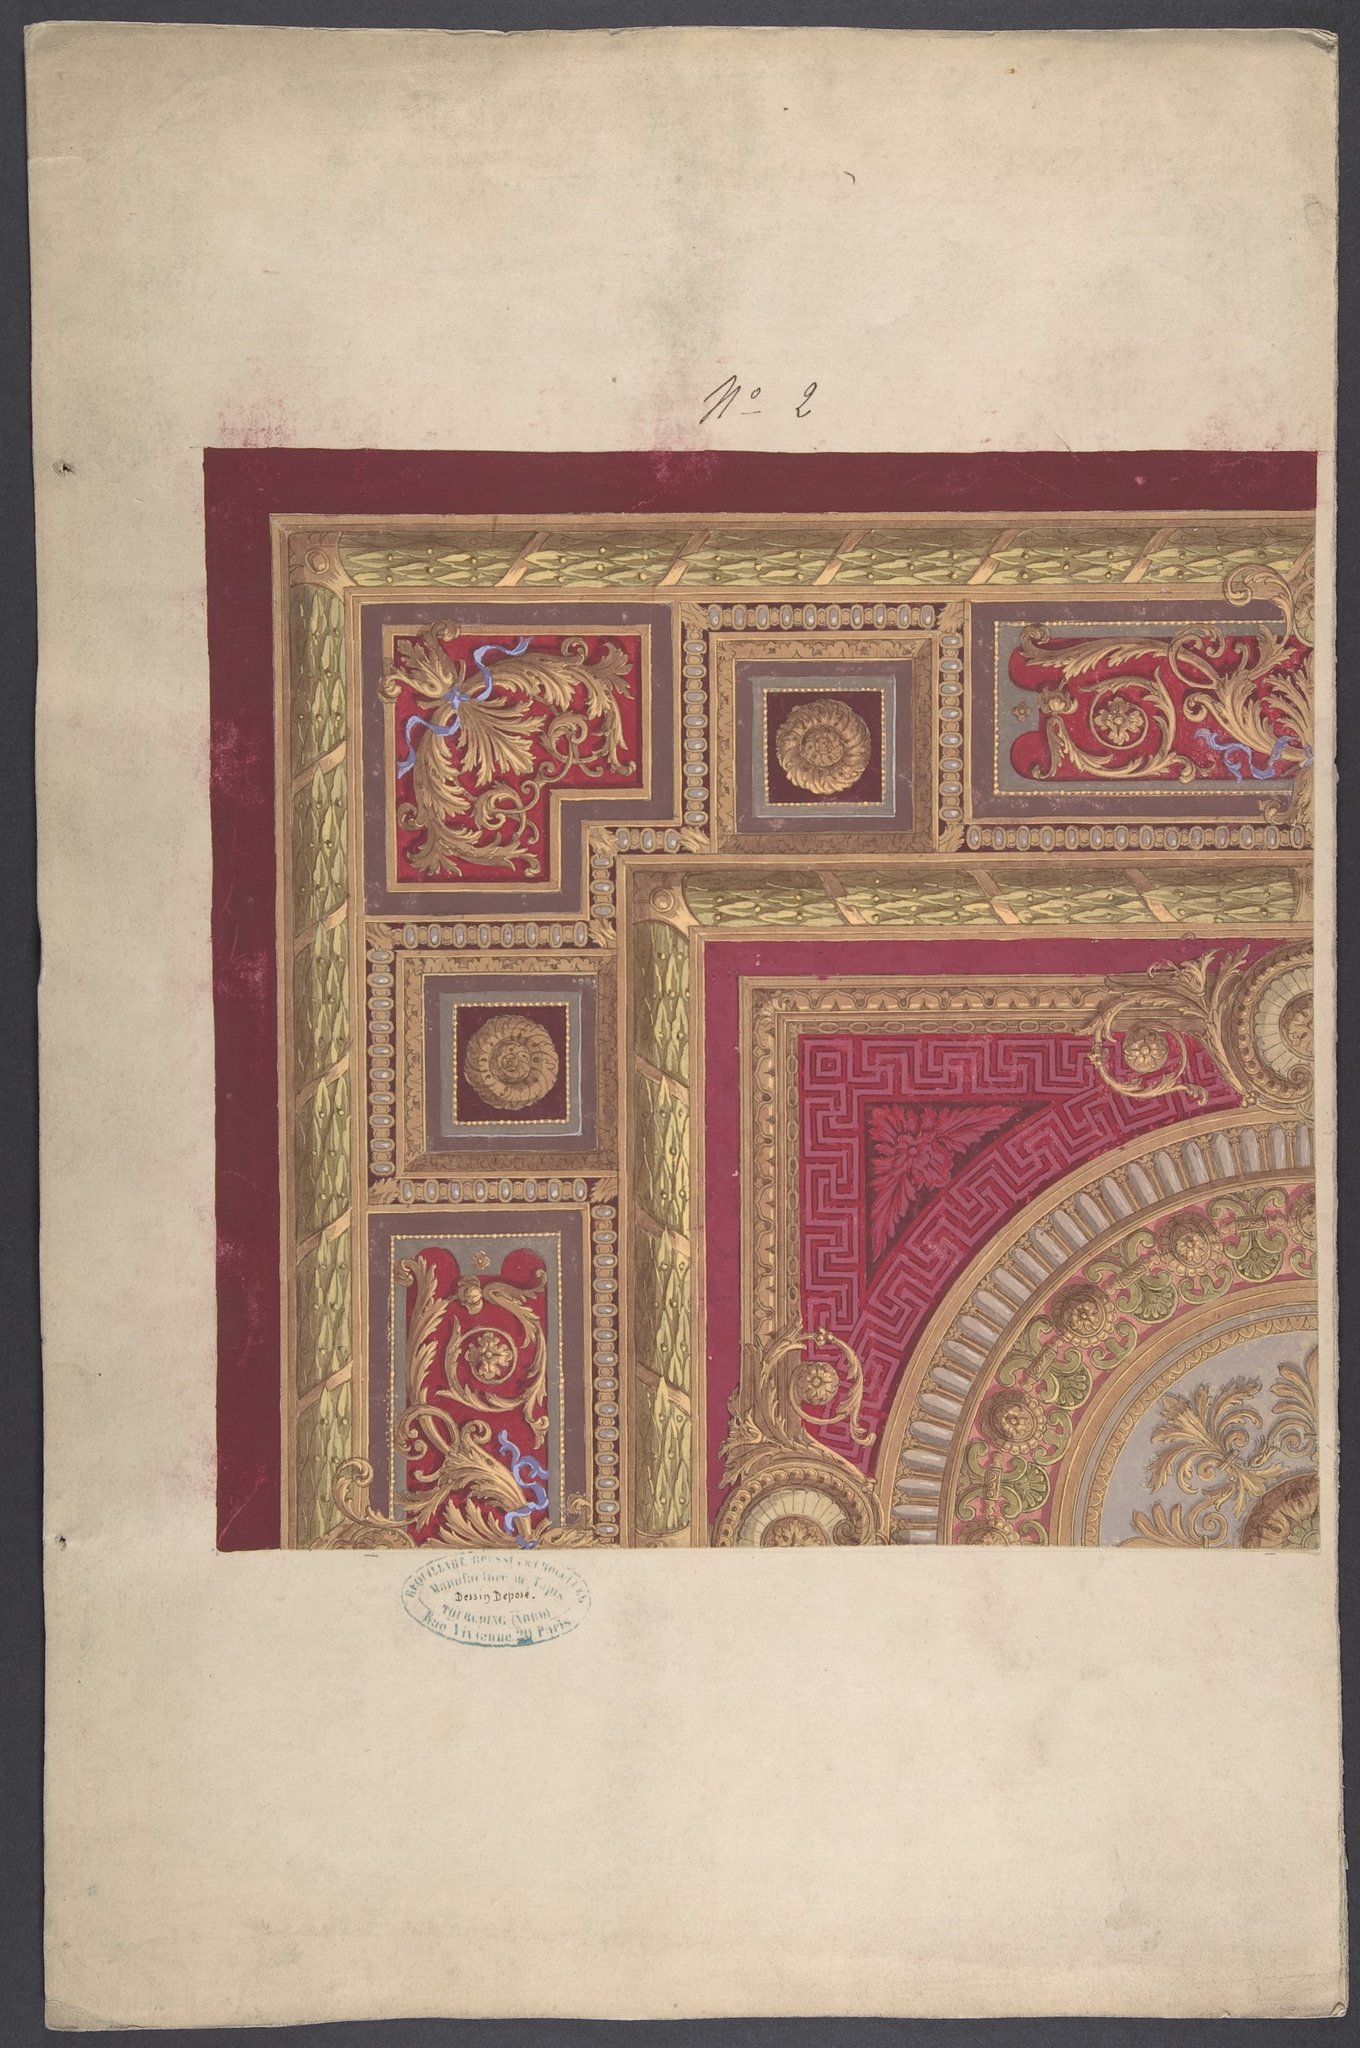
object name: drawing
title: Design for a Carpet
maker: anonymous, french, 19th century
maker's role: artist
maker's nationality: french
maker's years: 1800-1900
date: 1801-1900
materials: gouache, ink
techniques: pen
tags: ornament,flowers